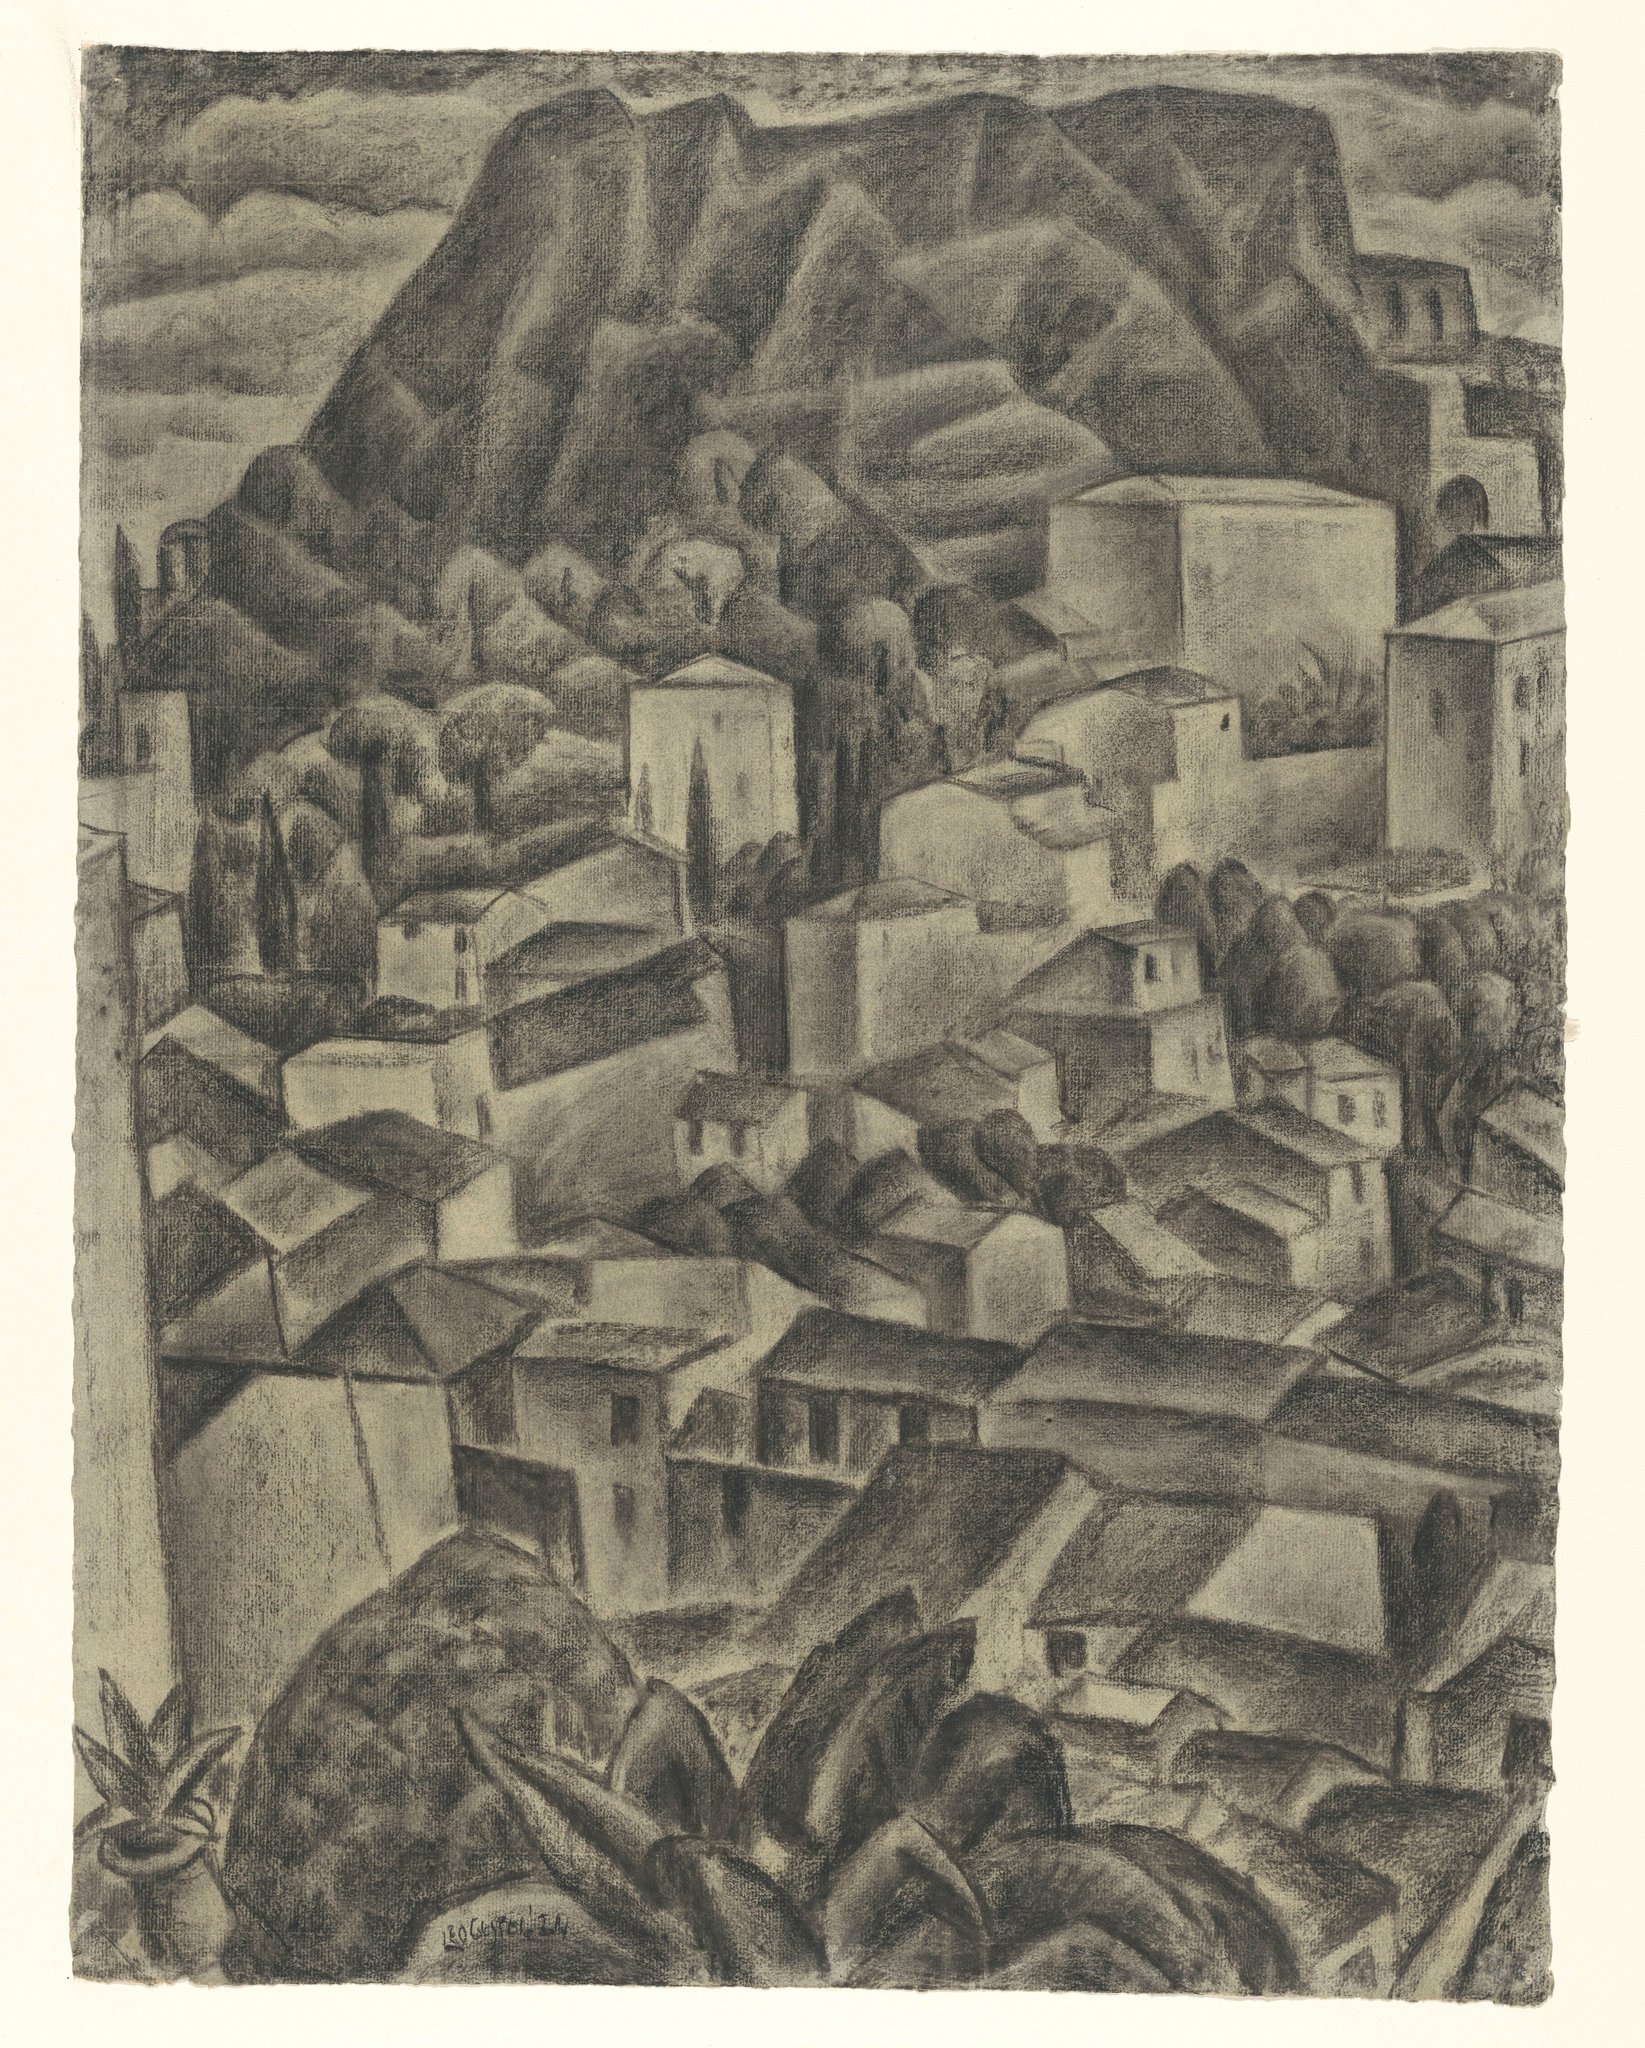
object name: drawing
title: Italiaans bergdorp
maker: leo gestel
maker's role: draughtsman, print maker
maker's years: 1881-1941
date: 1924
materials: chalk, paper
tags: prospect of village, silhouette of village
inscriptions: collector's mark: Lugt 2228